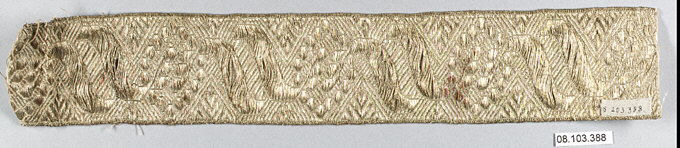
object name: galloon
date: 1601-1800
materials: metal thread